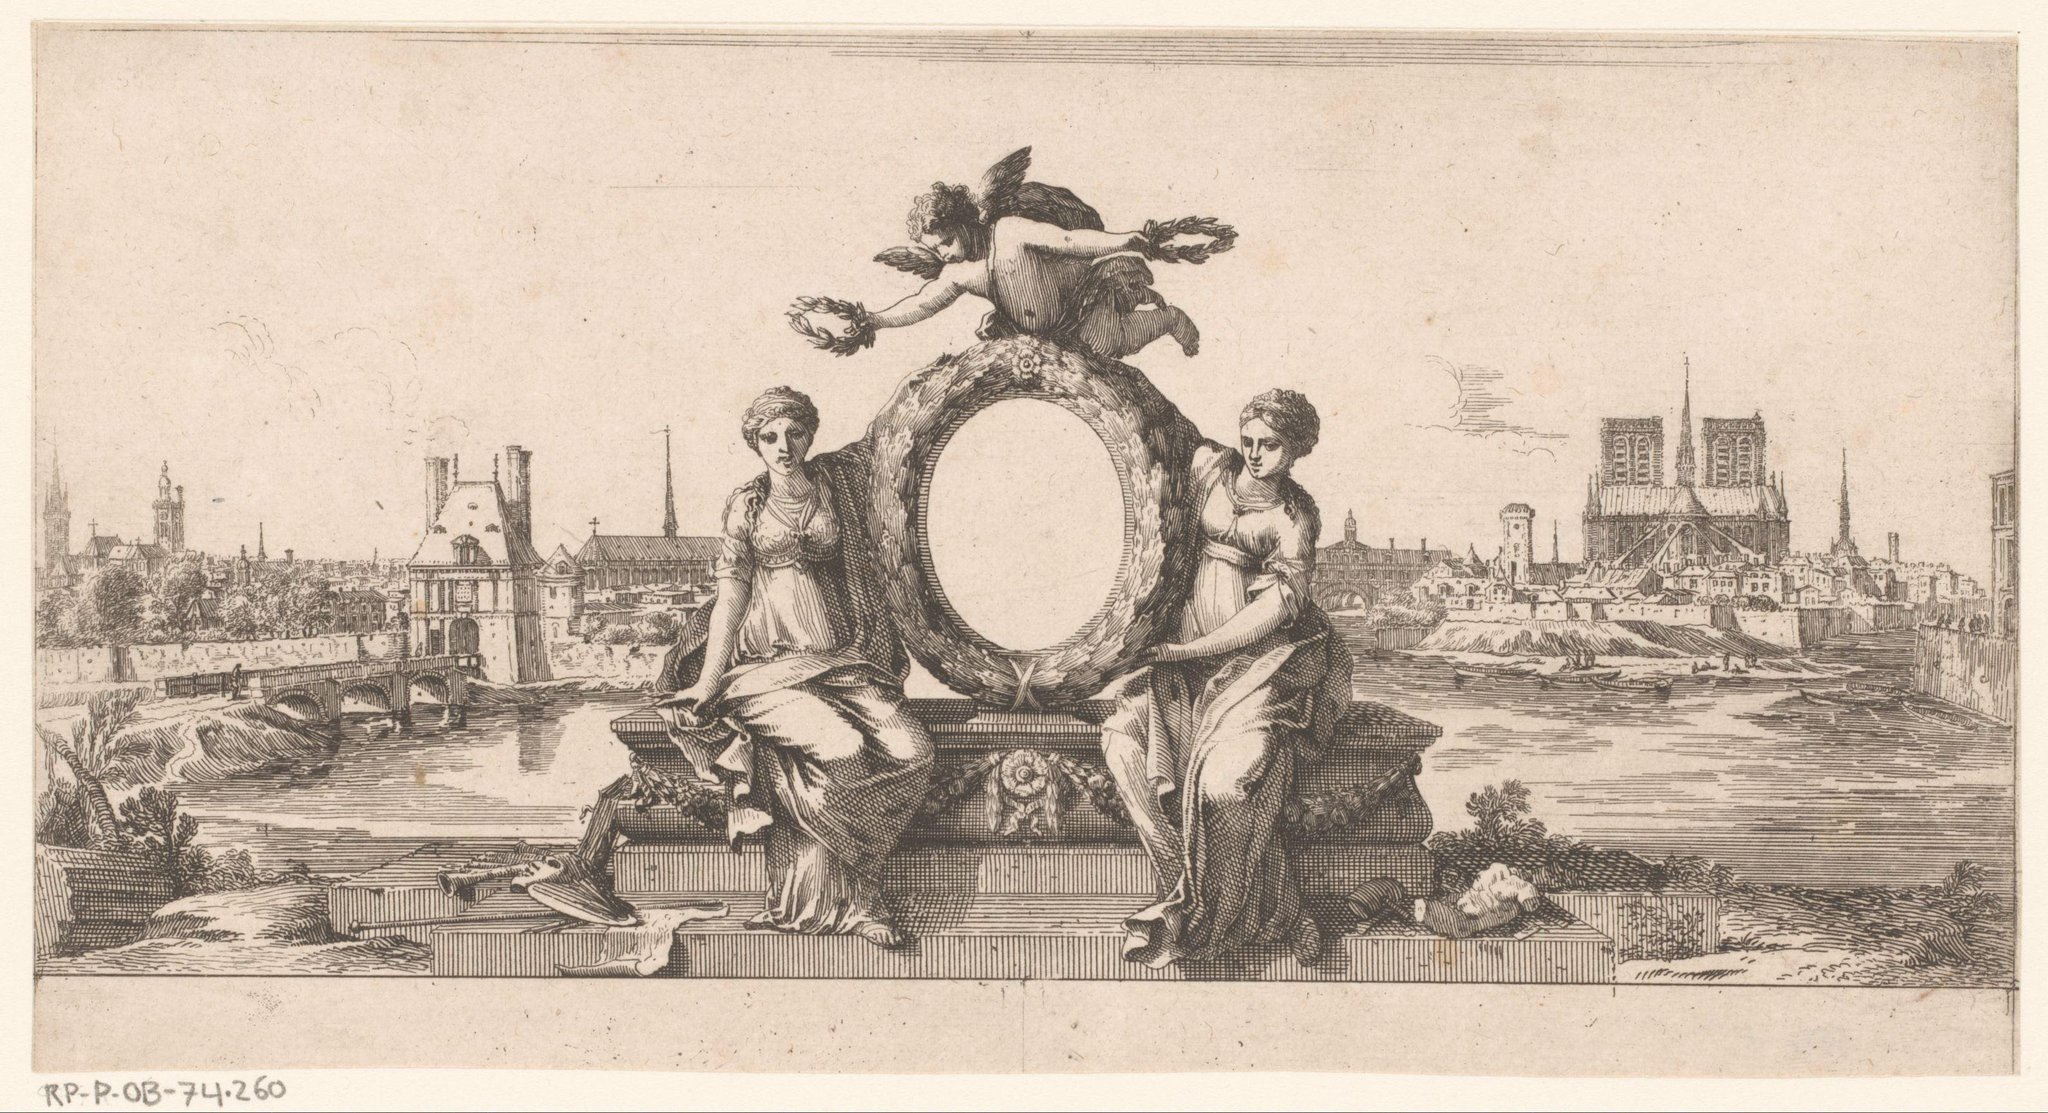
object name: titelprent, frontispice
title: Vues de Paris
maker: israël silvestre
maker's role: draughtsman, print maker, publisher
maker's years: 1621-1691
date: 1631-1691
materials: paper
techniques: etching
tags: city-view in general; 'veduta', paris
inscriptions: collector's mark: Lugt 240